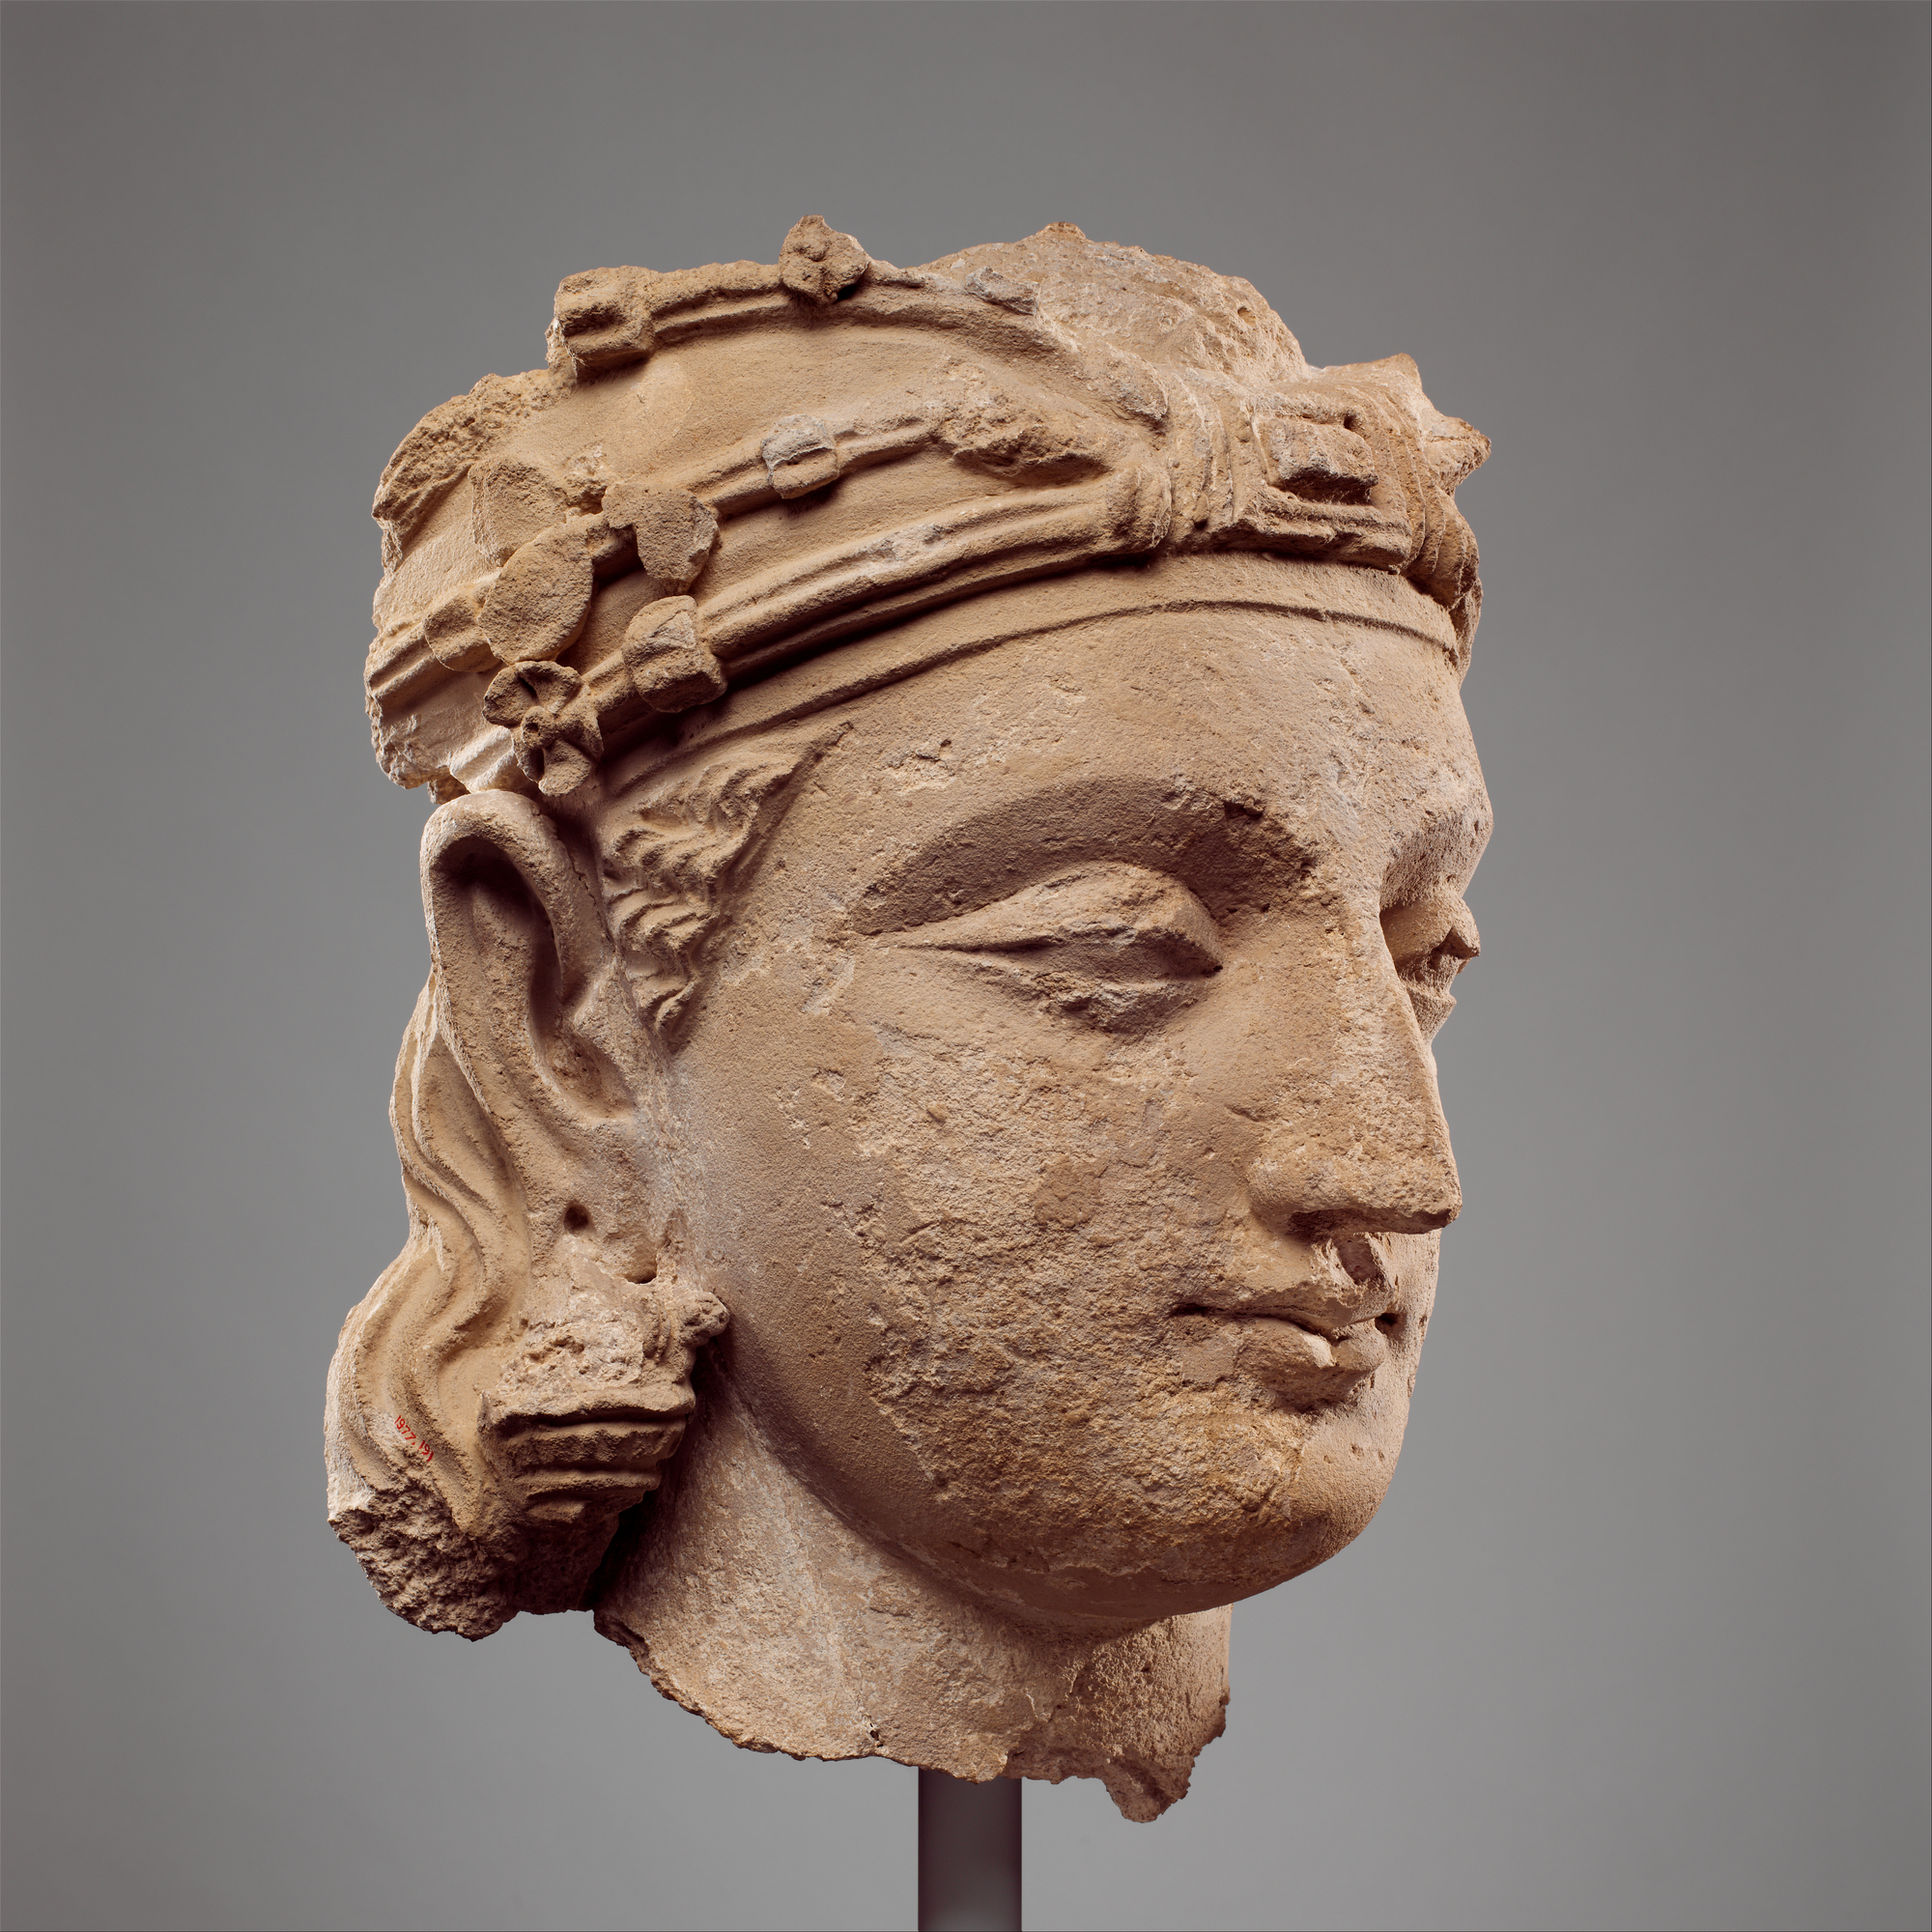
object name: head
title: Monumental Bodhisattva Head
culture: gandhara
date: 401-500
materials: plaster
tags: gandhara,heads,buddhism,bodhisattvas